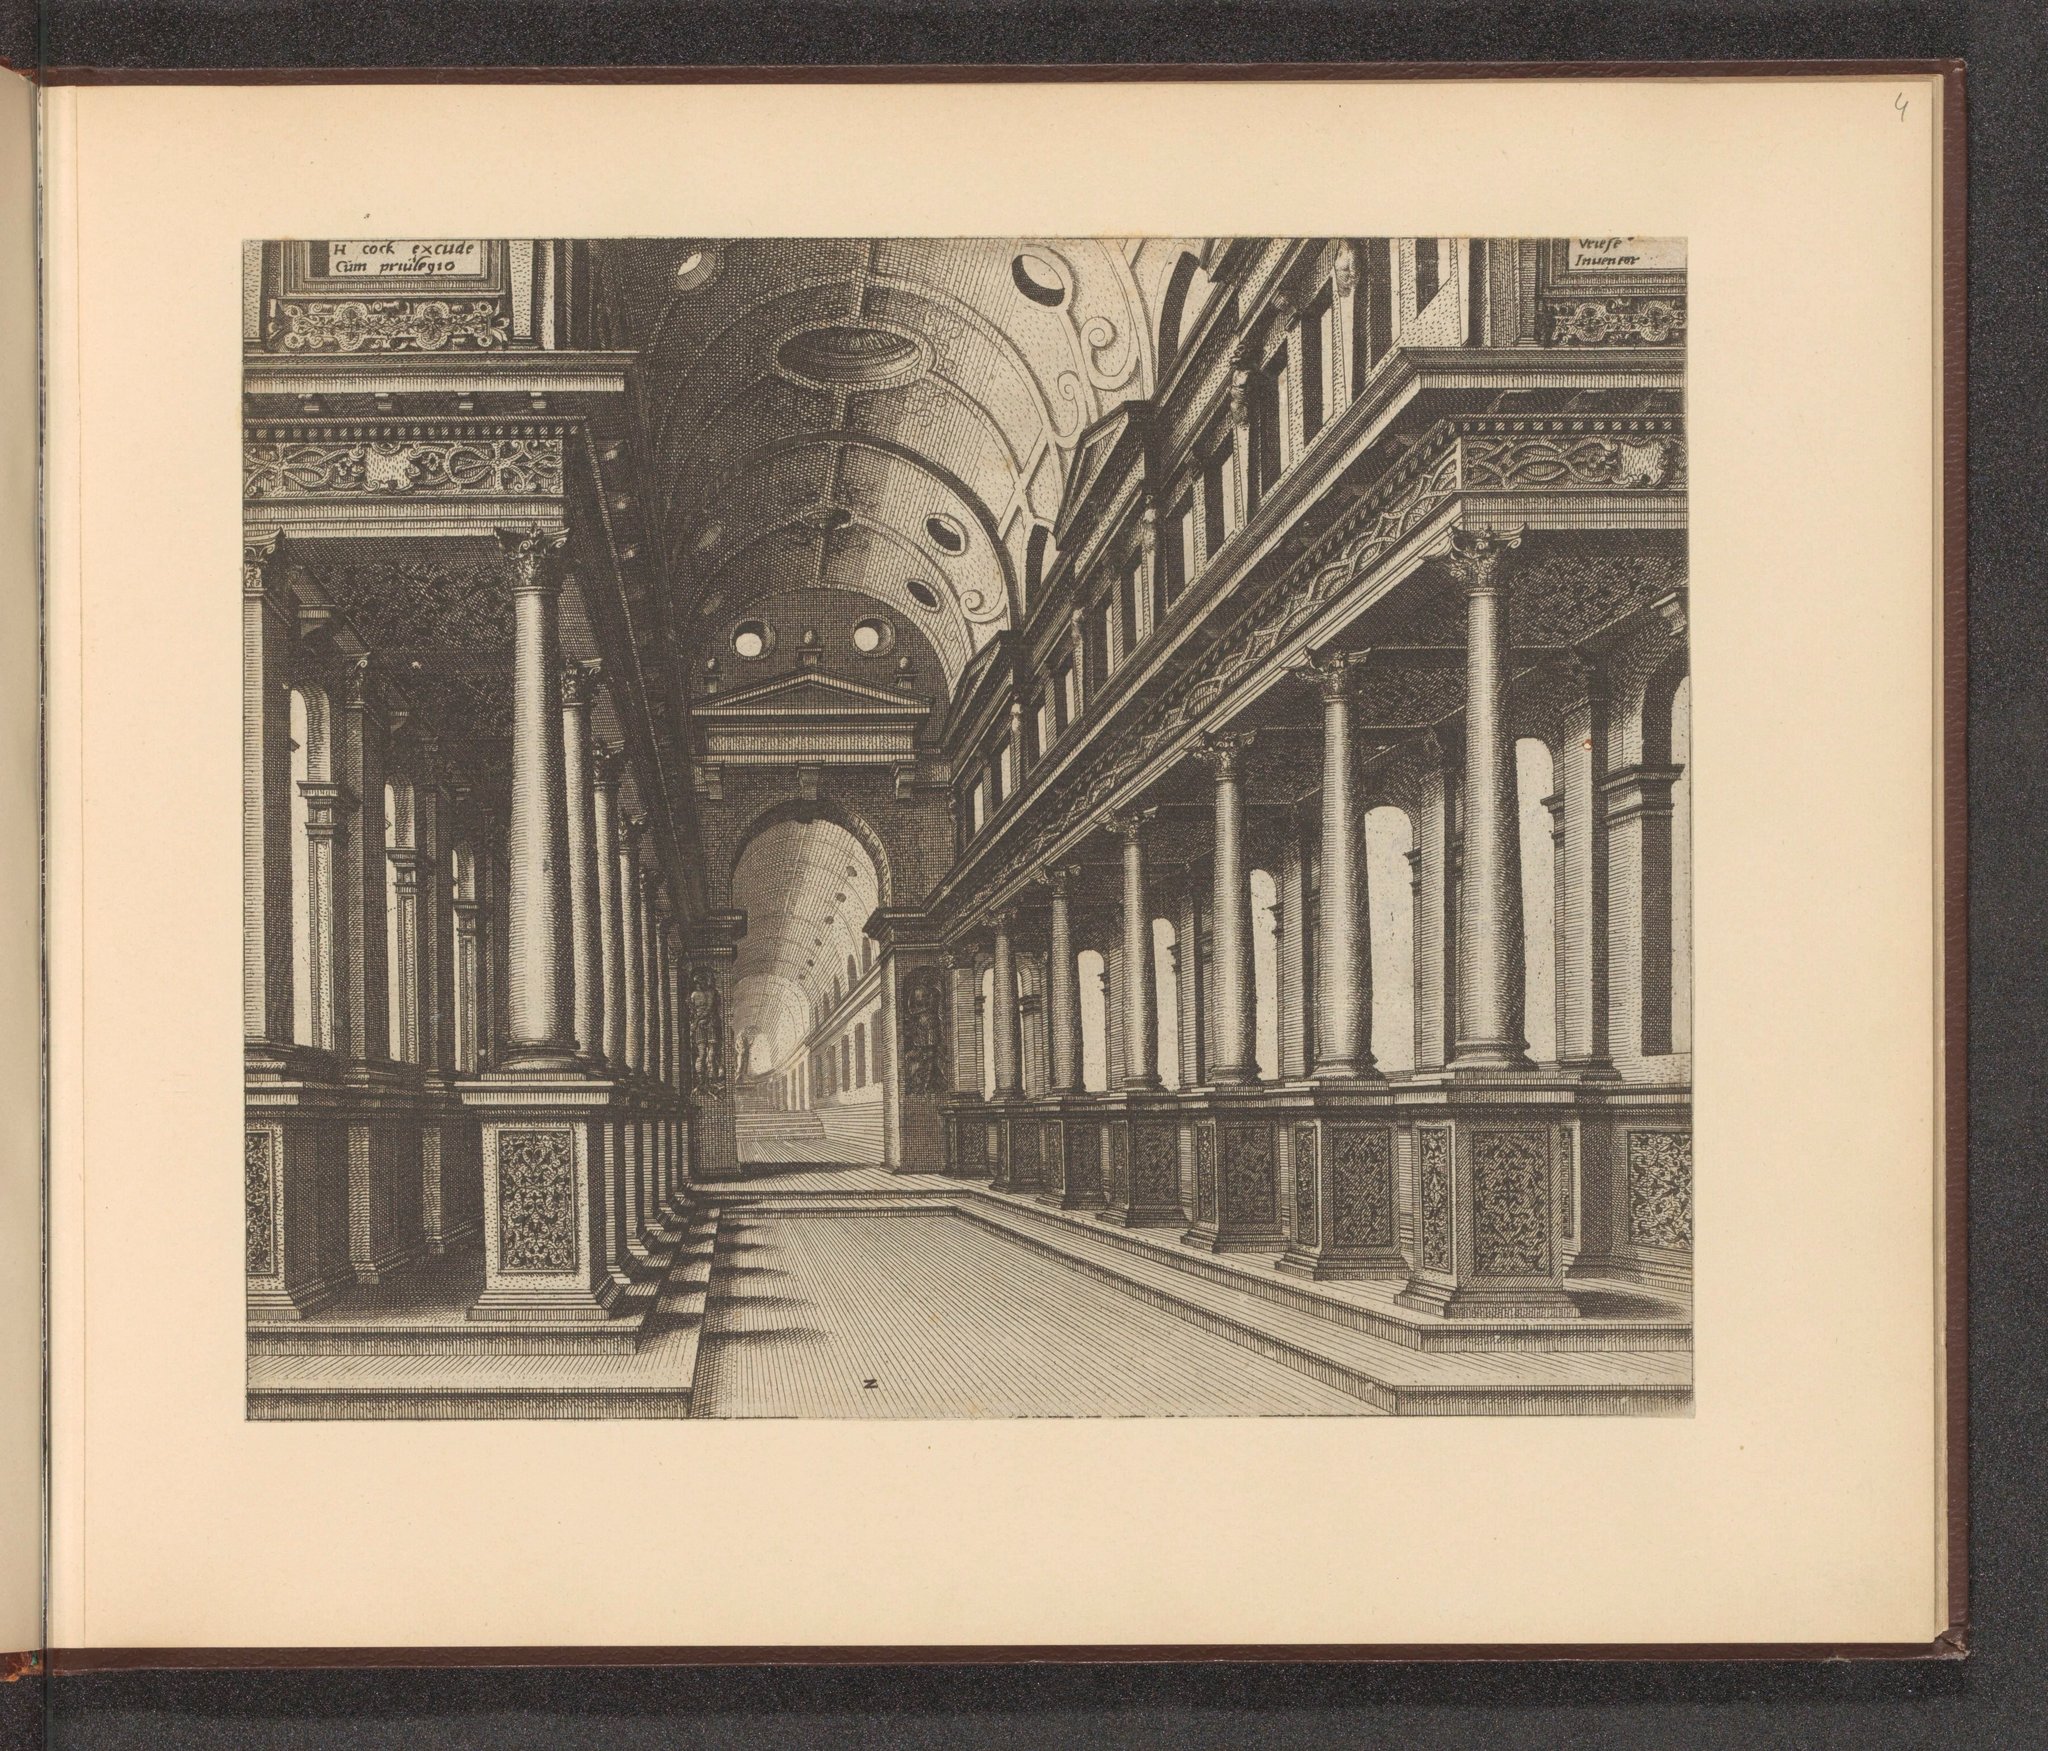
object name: album leaf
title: Interieur van een kerk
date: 1563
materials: paper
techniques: etching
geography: antwerp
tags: ornament ~ moresque, interior of church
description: Interieur van een kerk met in de verte een standbeeld op een piëdestal. De piëdestallen van de zuilen zijn versierd met moresken. Prent maakt deel uit van een album.